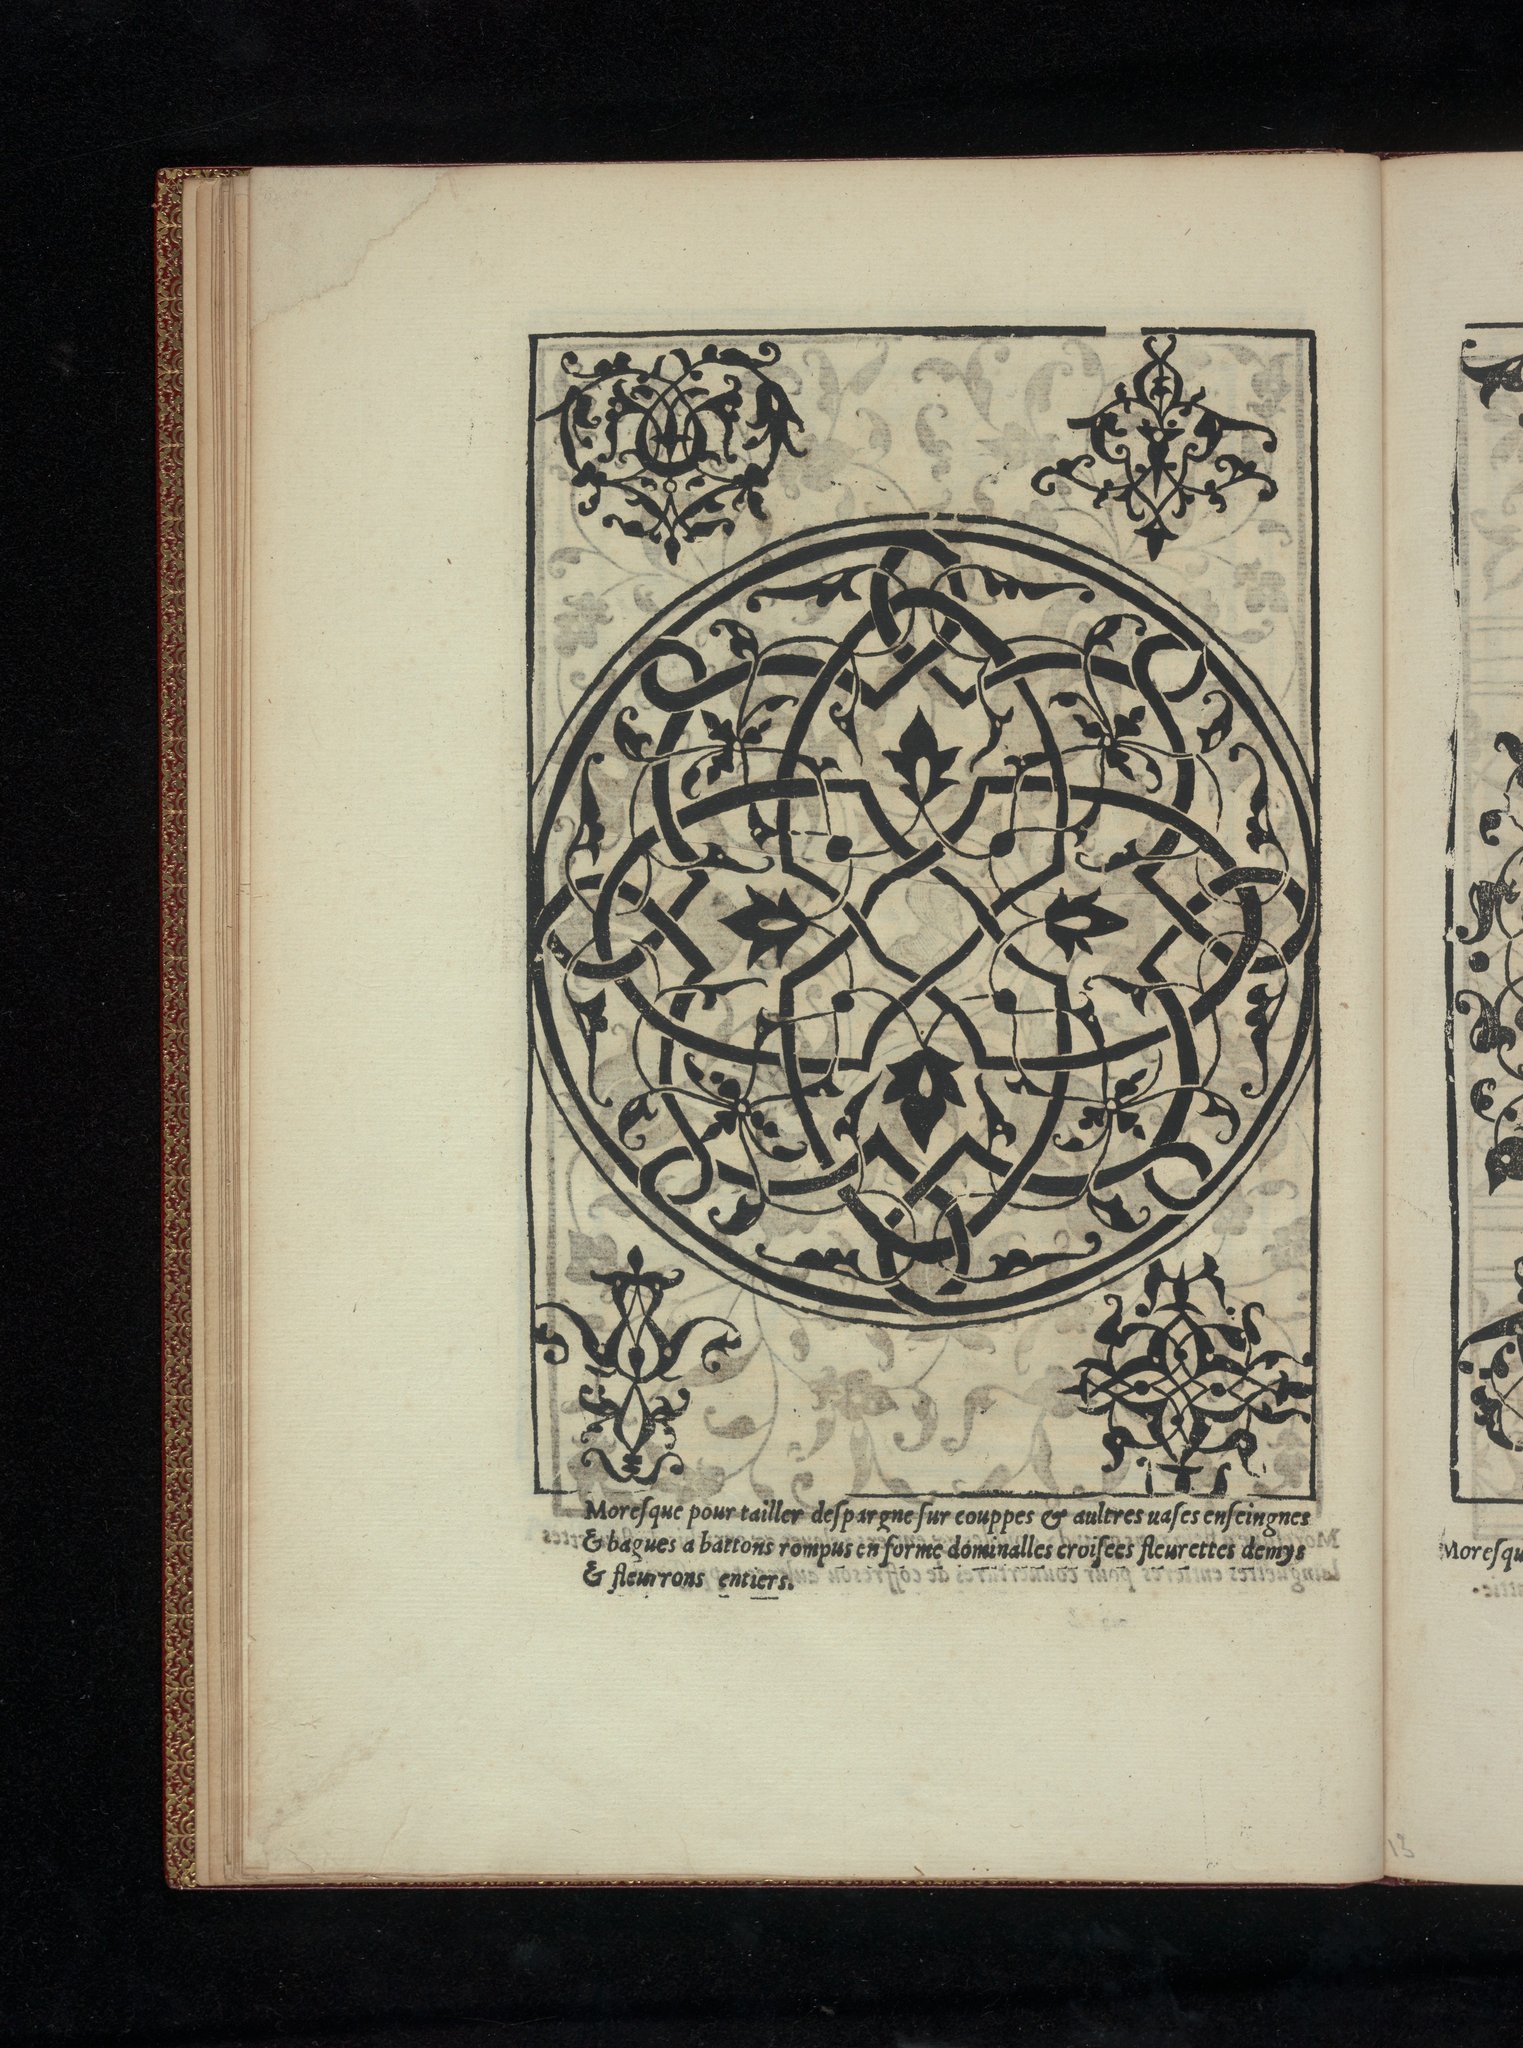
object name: book print ornament architecture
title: Livre de Moresques, page 7 (verso)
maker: francesco di pellegrino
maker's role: artist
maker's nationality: italian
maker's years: 1525-1552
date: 1546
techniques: woodcut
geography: france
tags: ornament